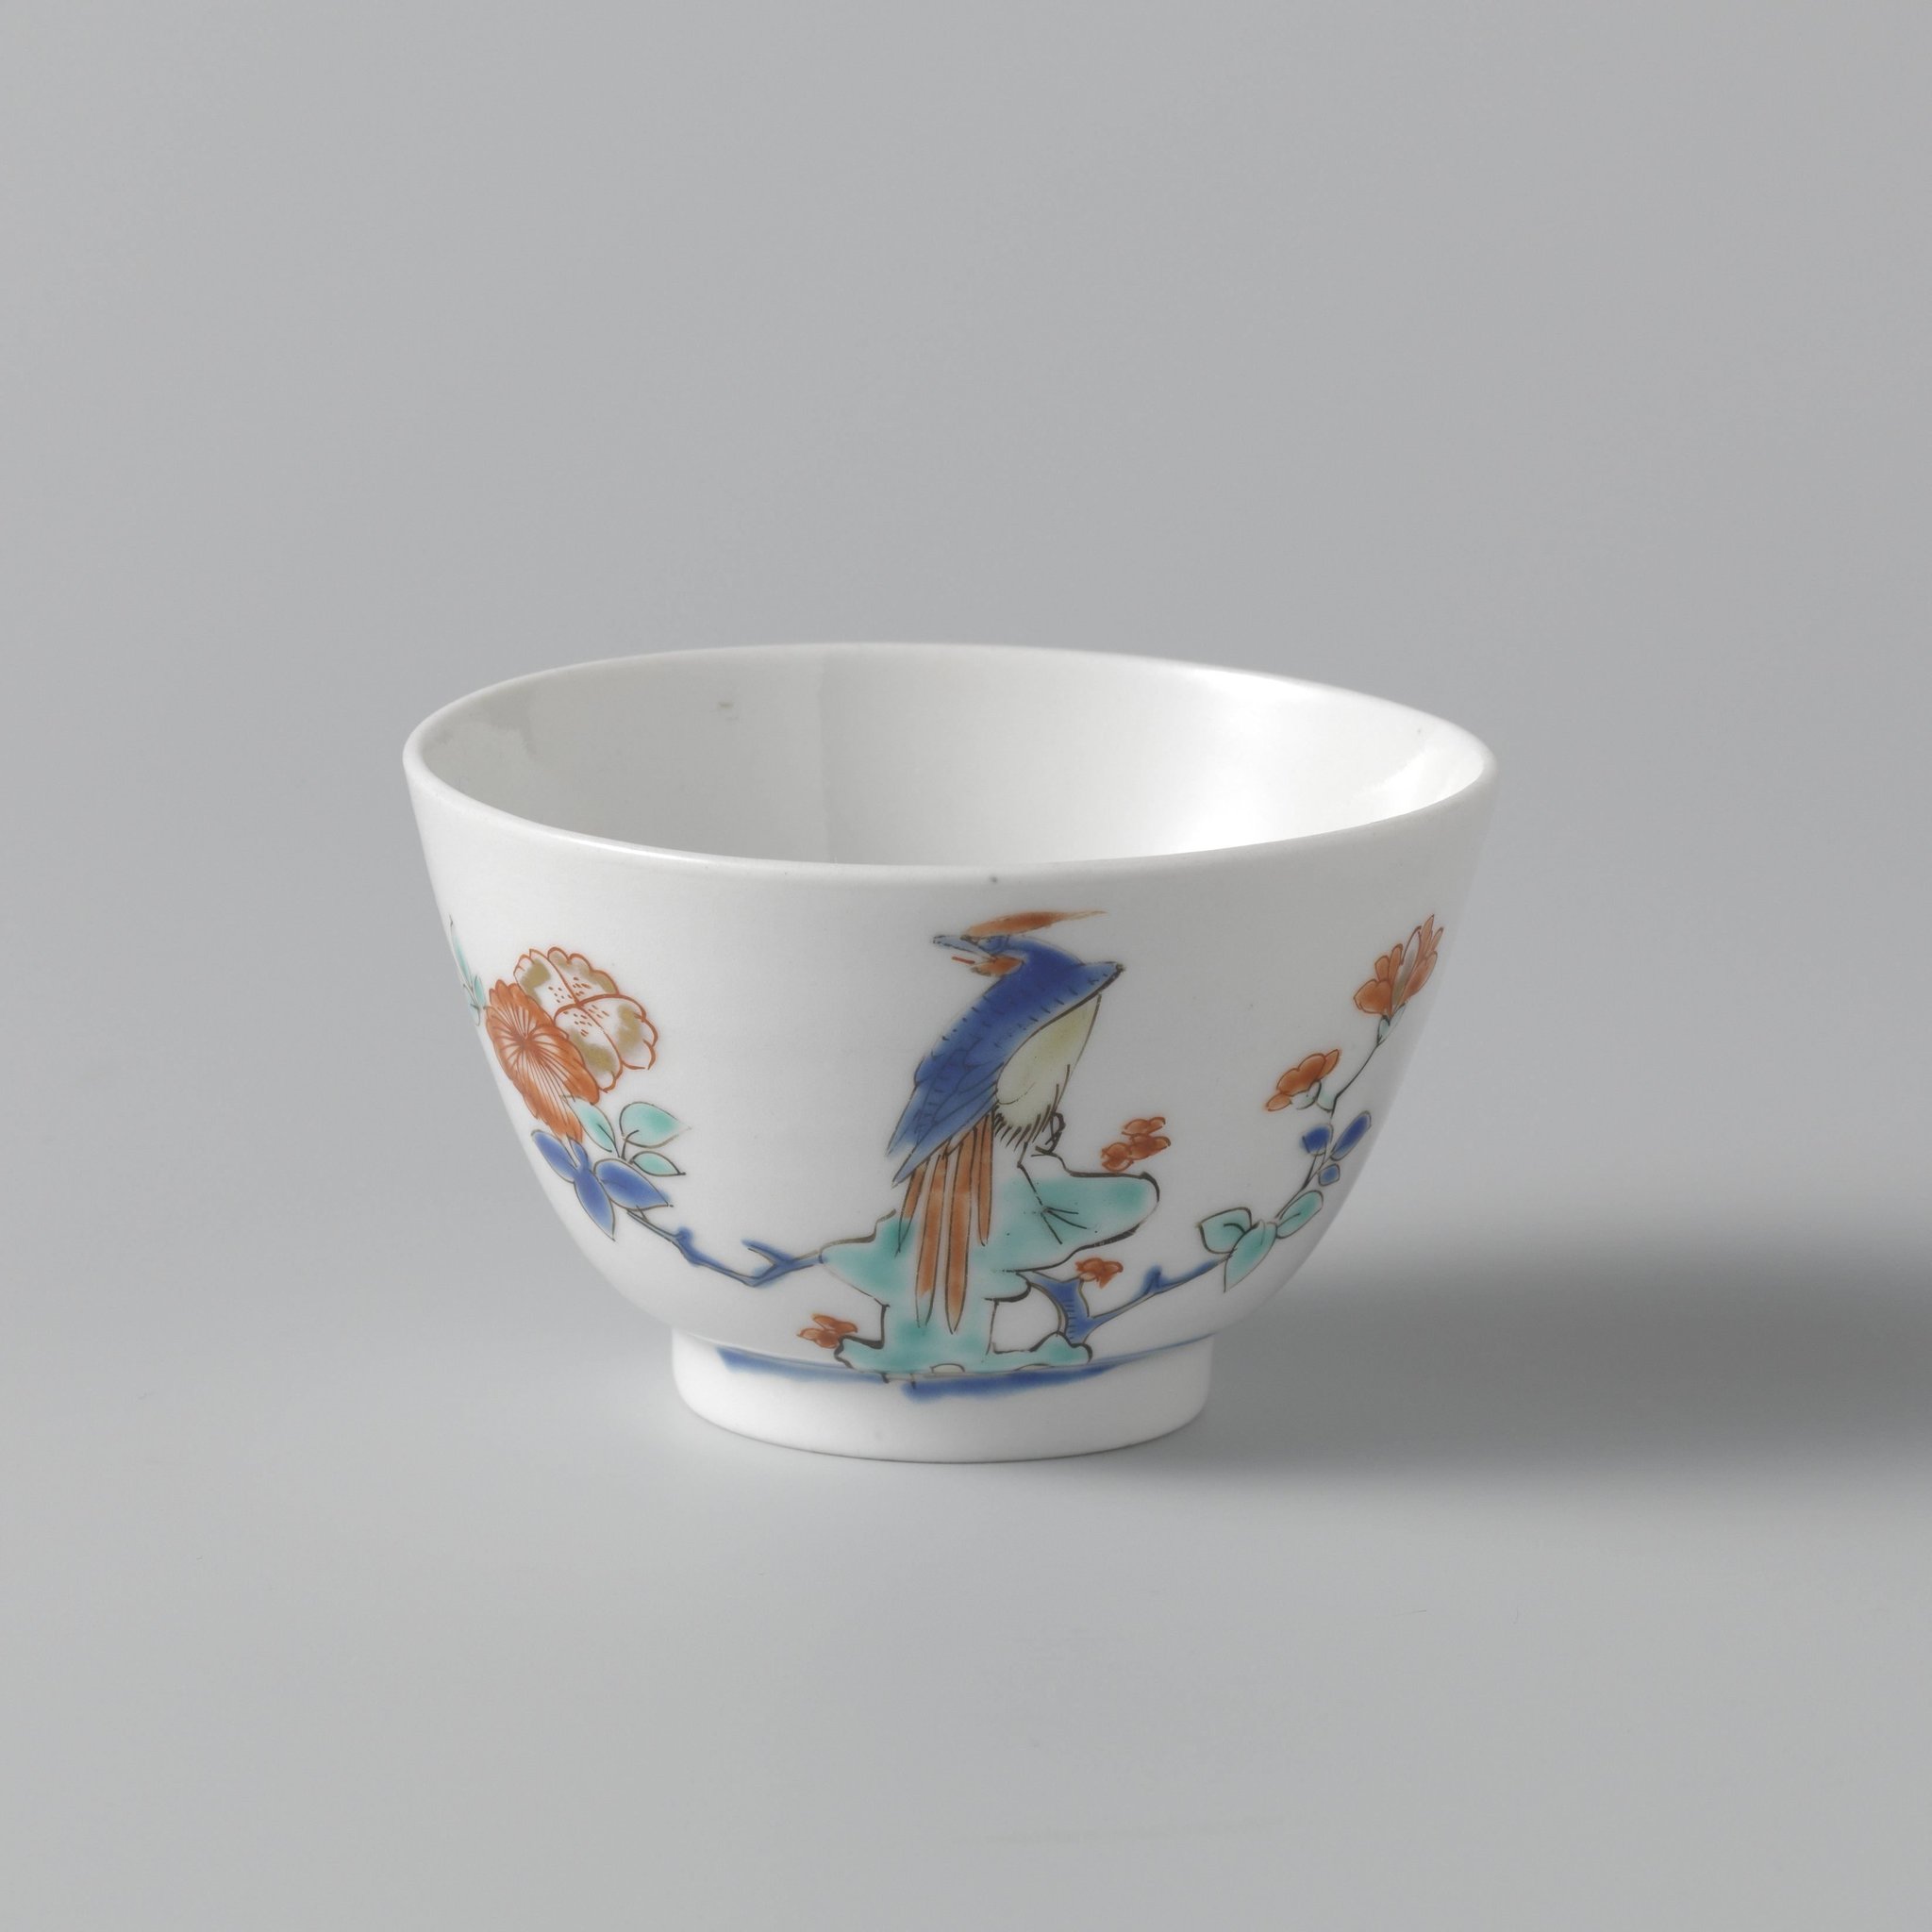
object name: cup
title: Cup with hoo birds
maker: Anonymous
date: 1670-1700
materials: glaze, gold, paint, porcelain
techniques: firing, gilding, turning, vitrification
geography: arita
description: Two cups and a saucer, c. 1700 - 1725.